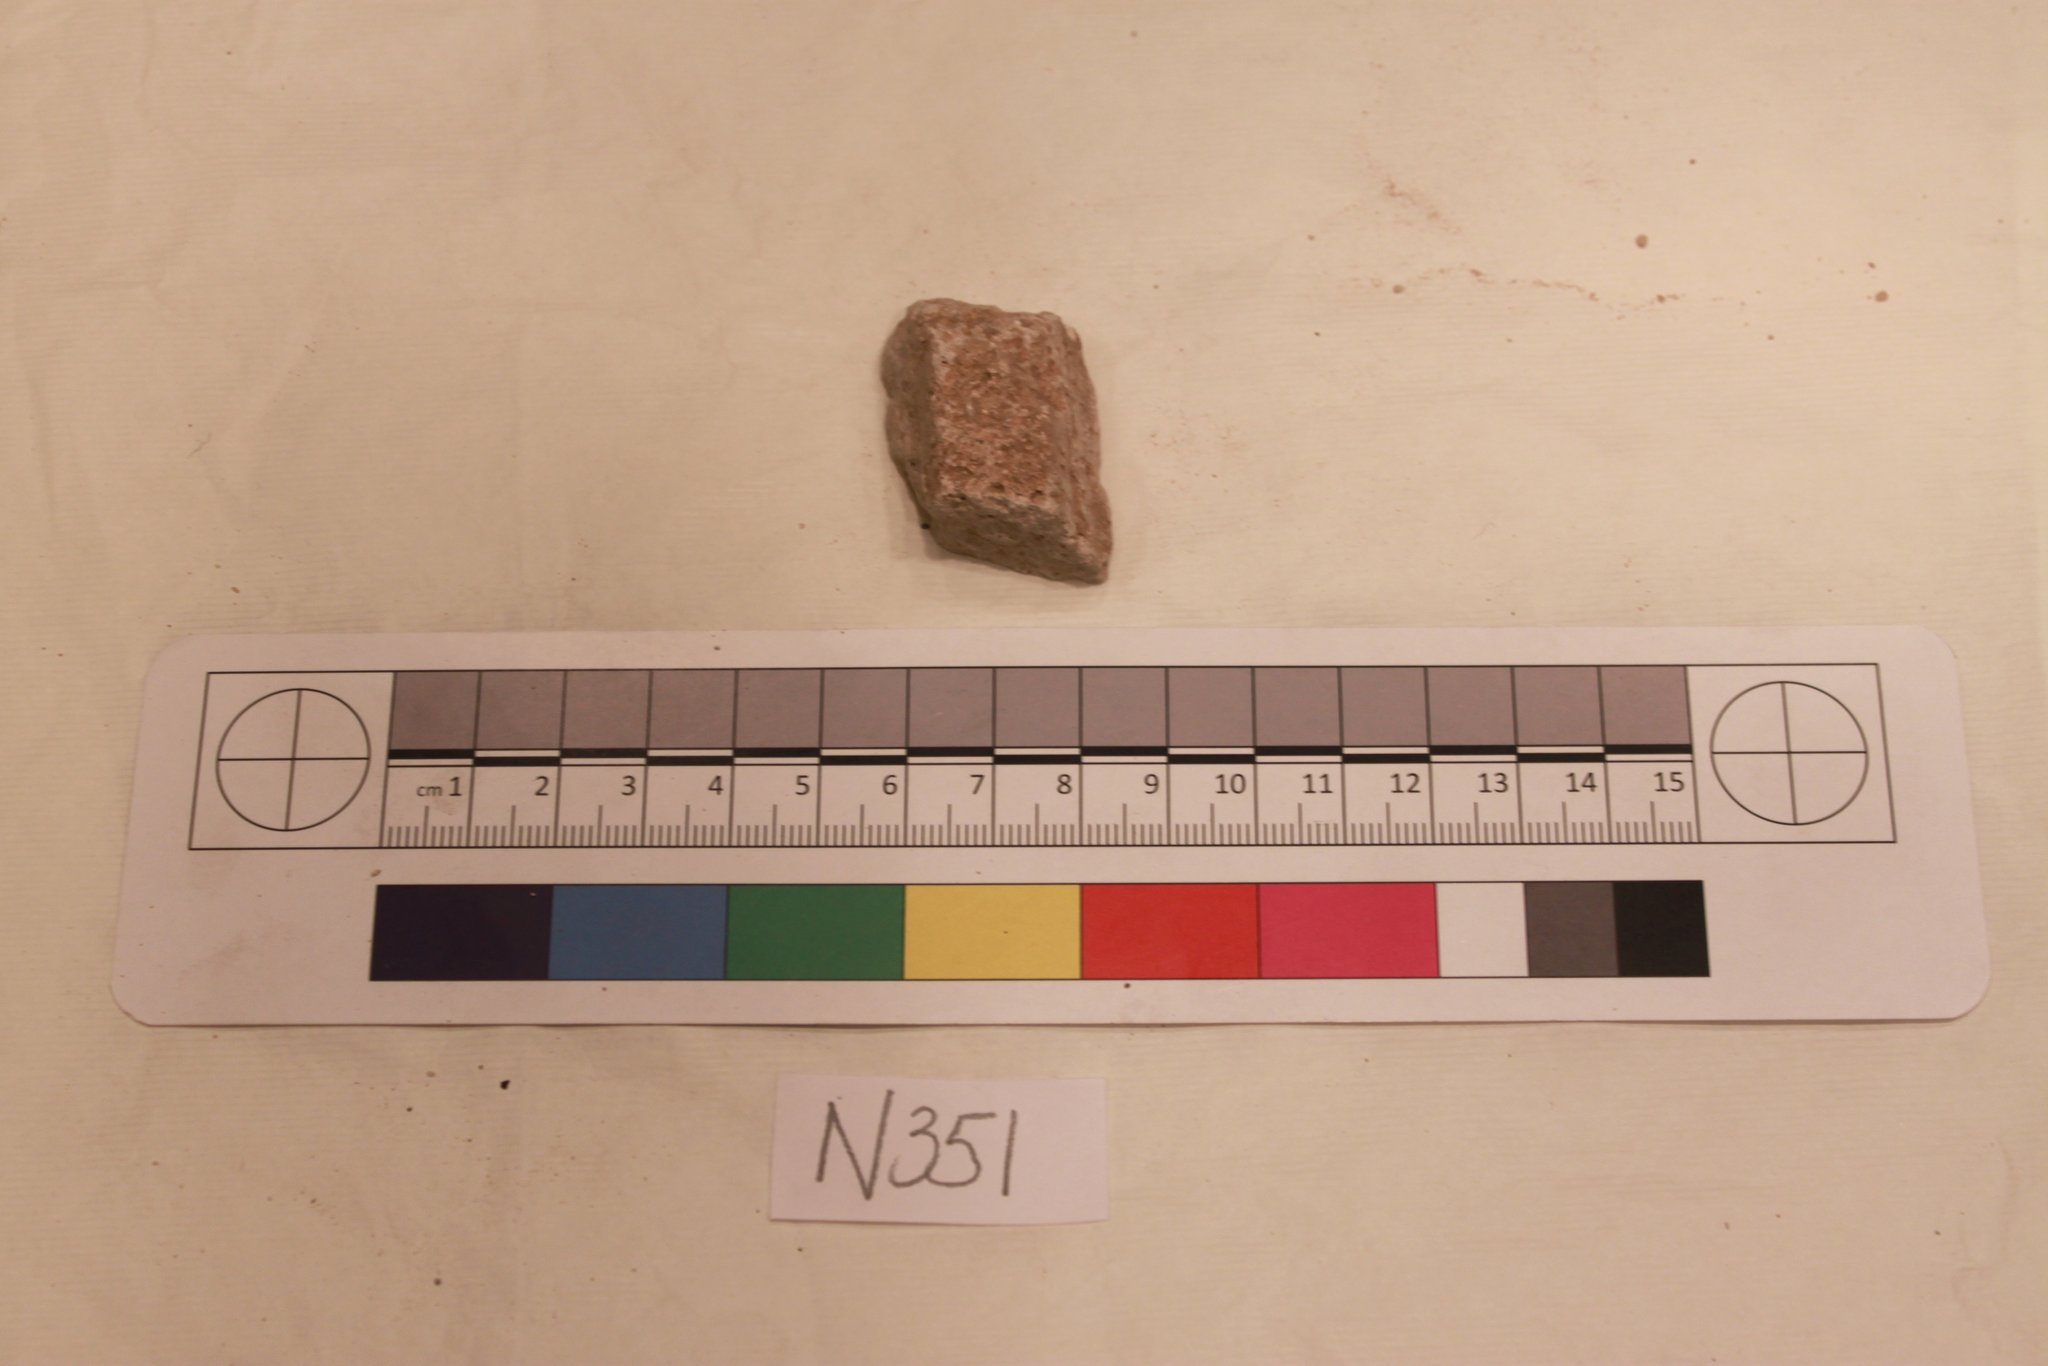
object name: fragment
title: Stucco Fragment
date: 701-1200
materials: plaster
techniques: carving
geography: iran